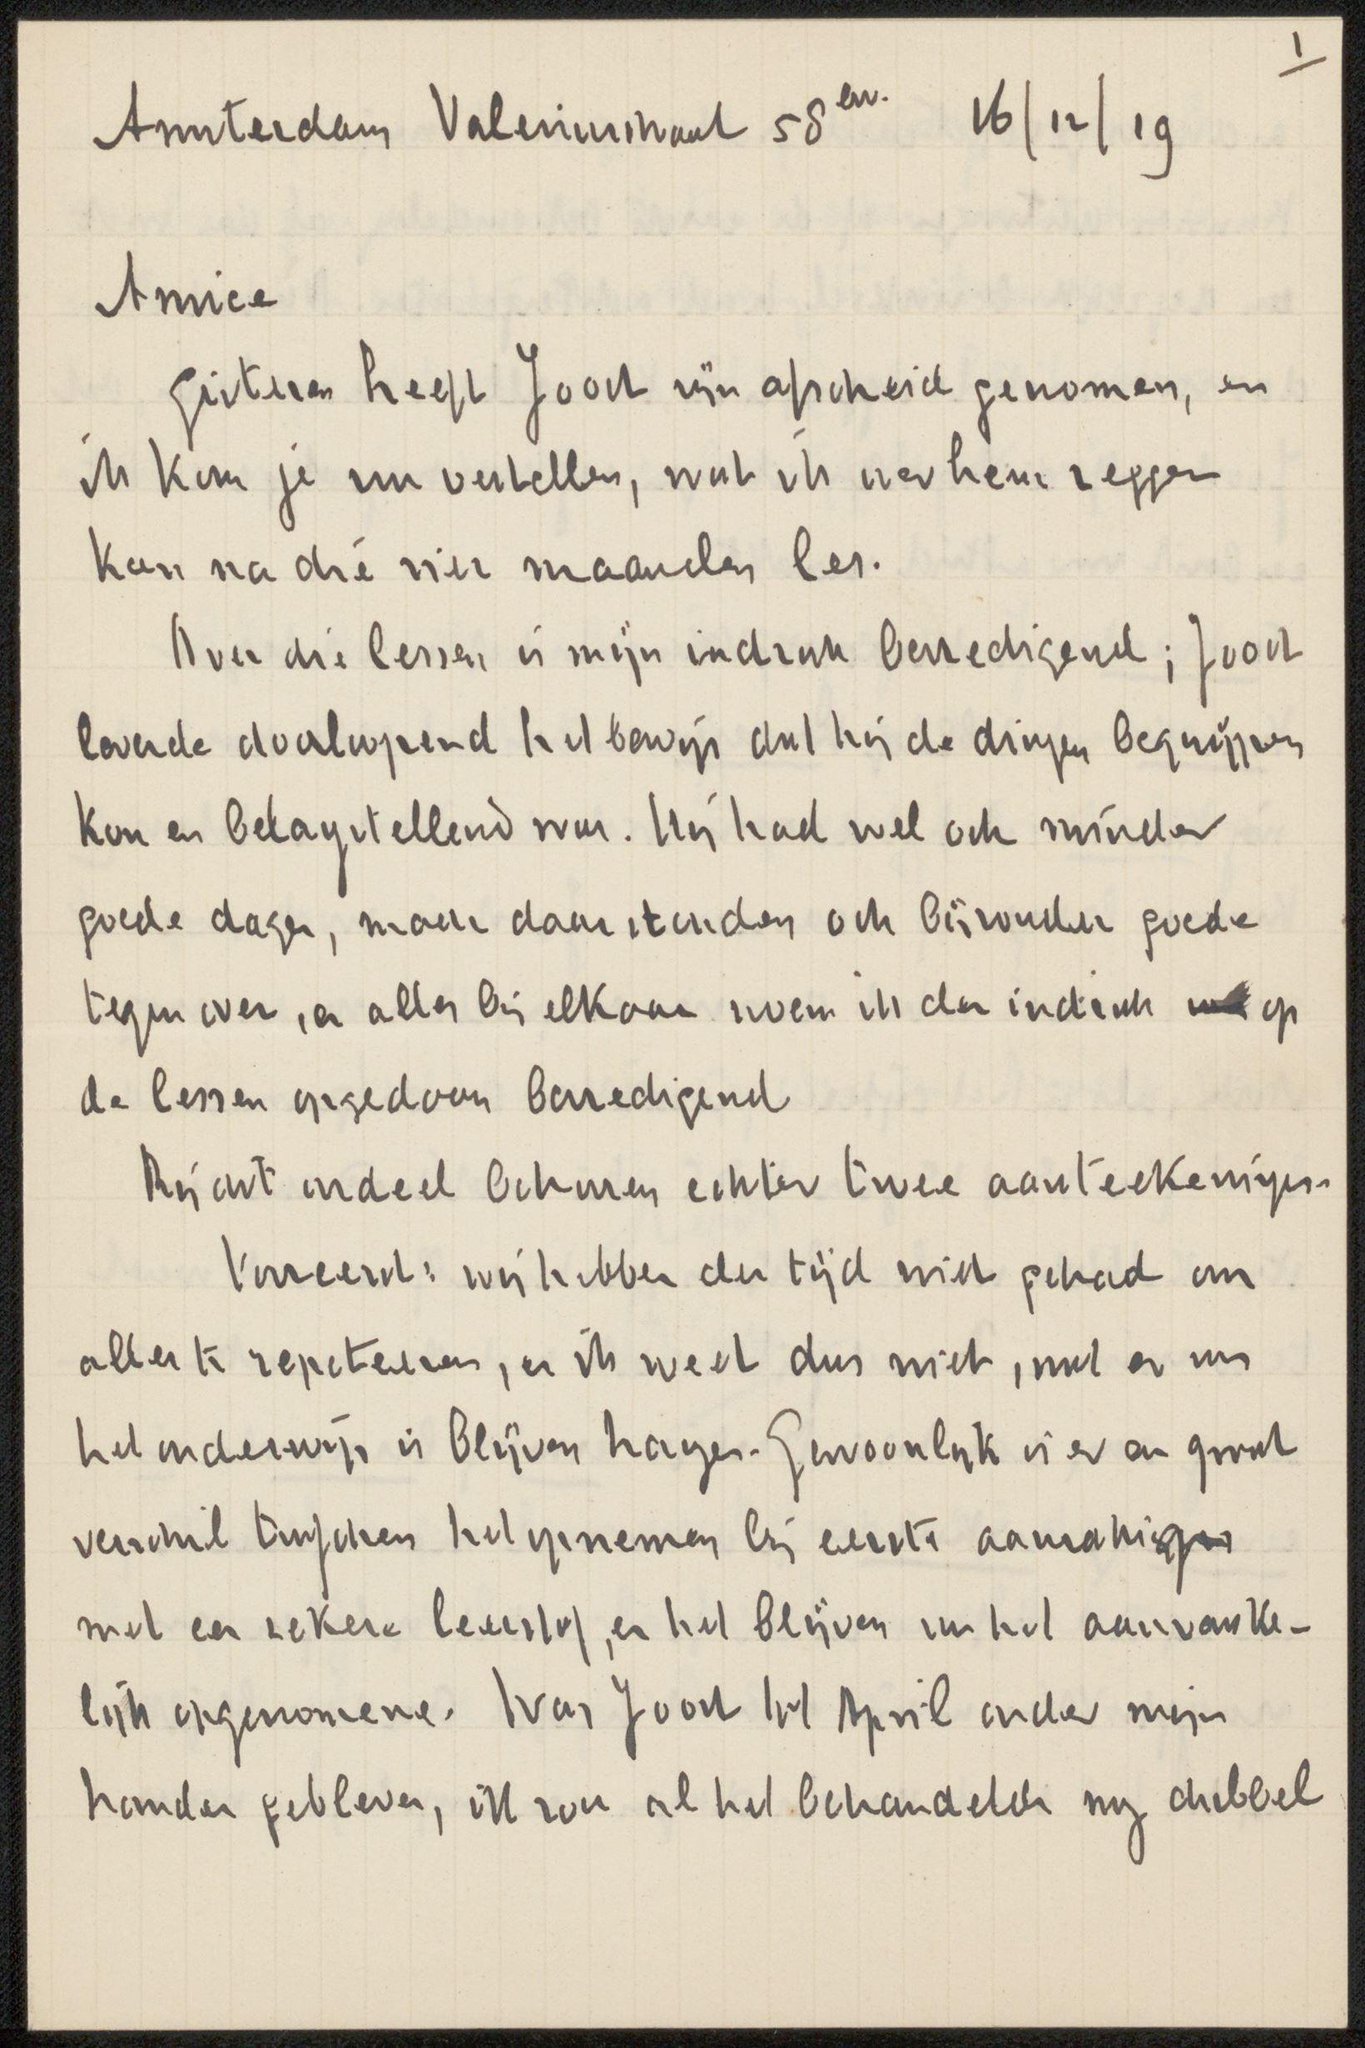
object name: letter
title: Brief aan Jan Veth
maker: chap van deventer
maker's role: kunstcriticus, scheikundige, schrijver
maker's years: 1860-1931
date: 1919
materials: ink, paper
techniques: pen, writing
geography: amsterdam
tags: dordrecht, amsterdam, painter, print maker, draughtsman, designer, jan veth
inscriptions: collector's mark: ‘RPK’